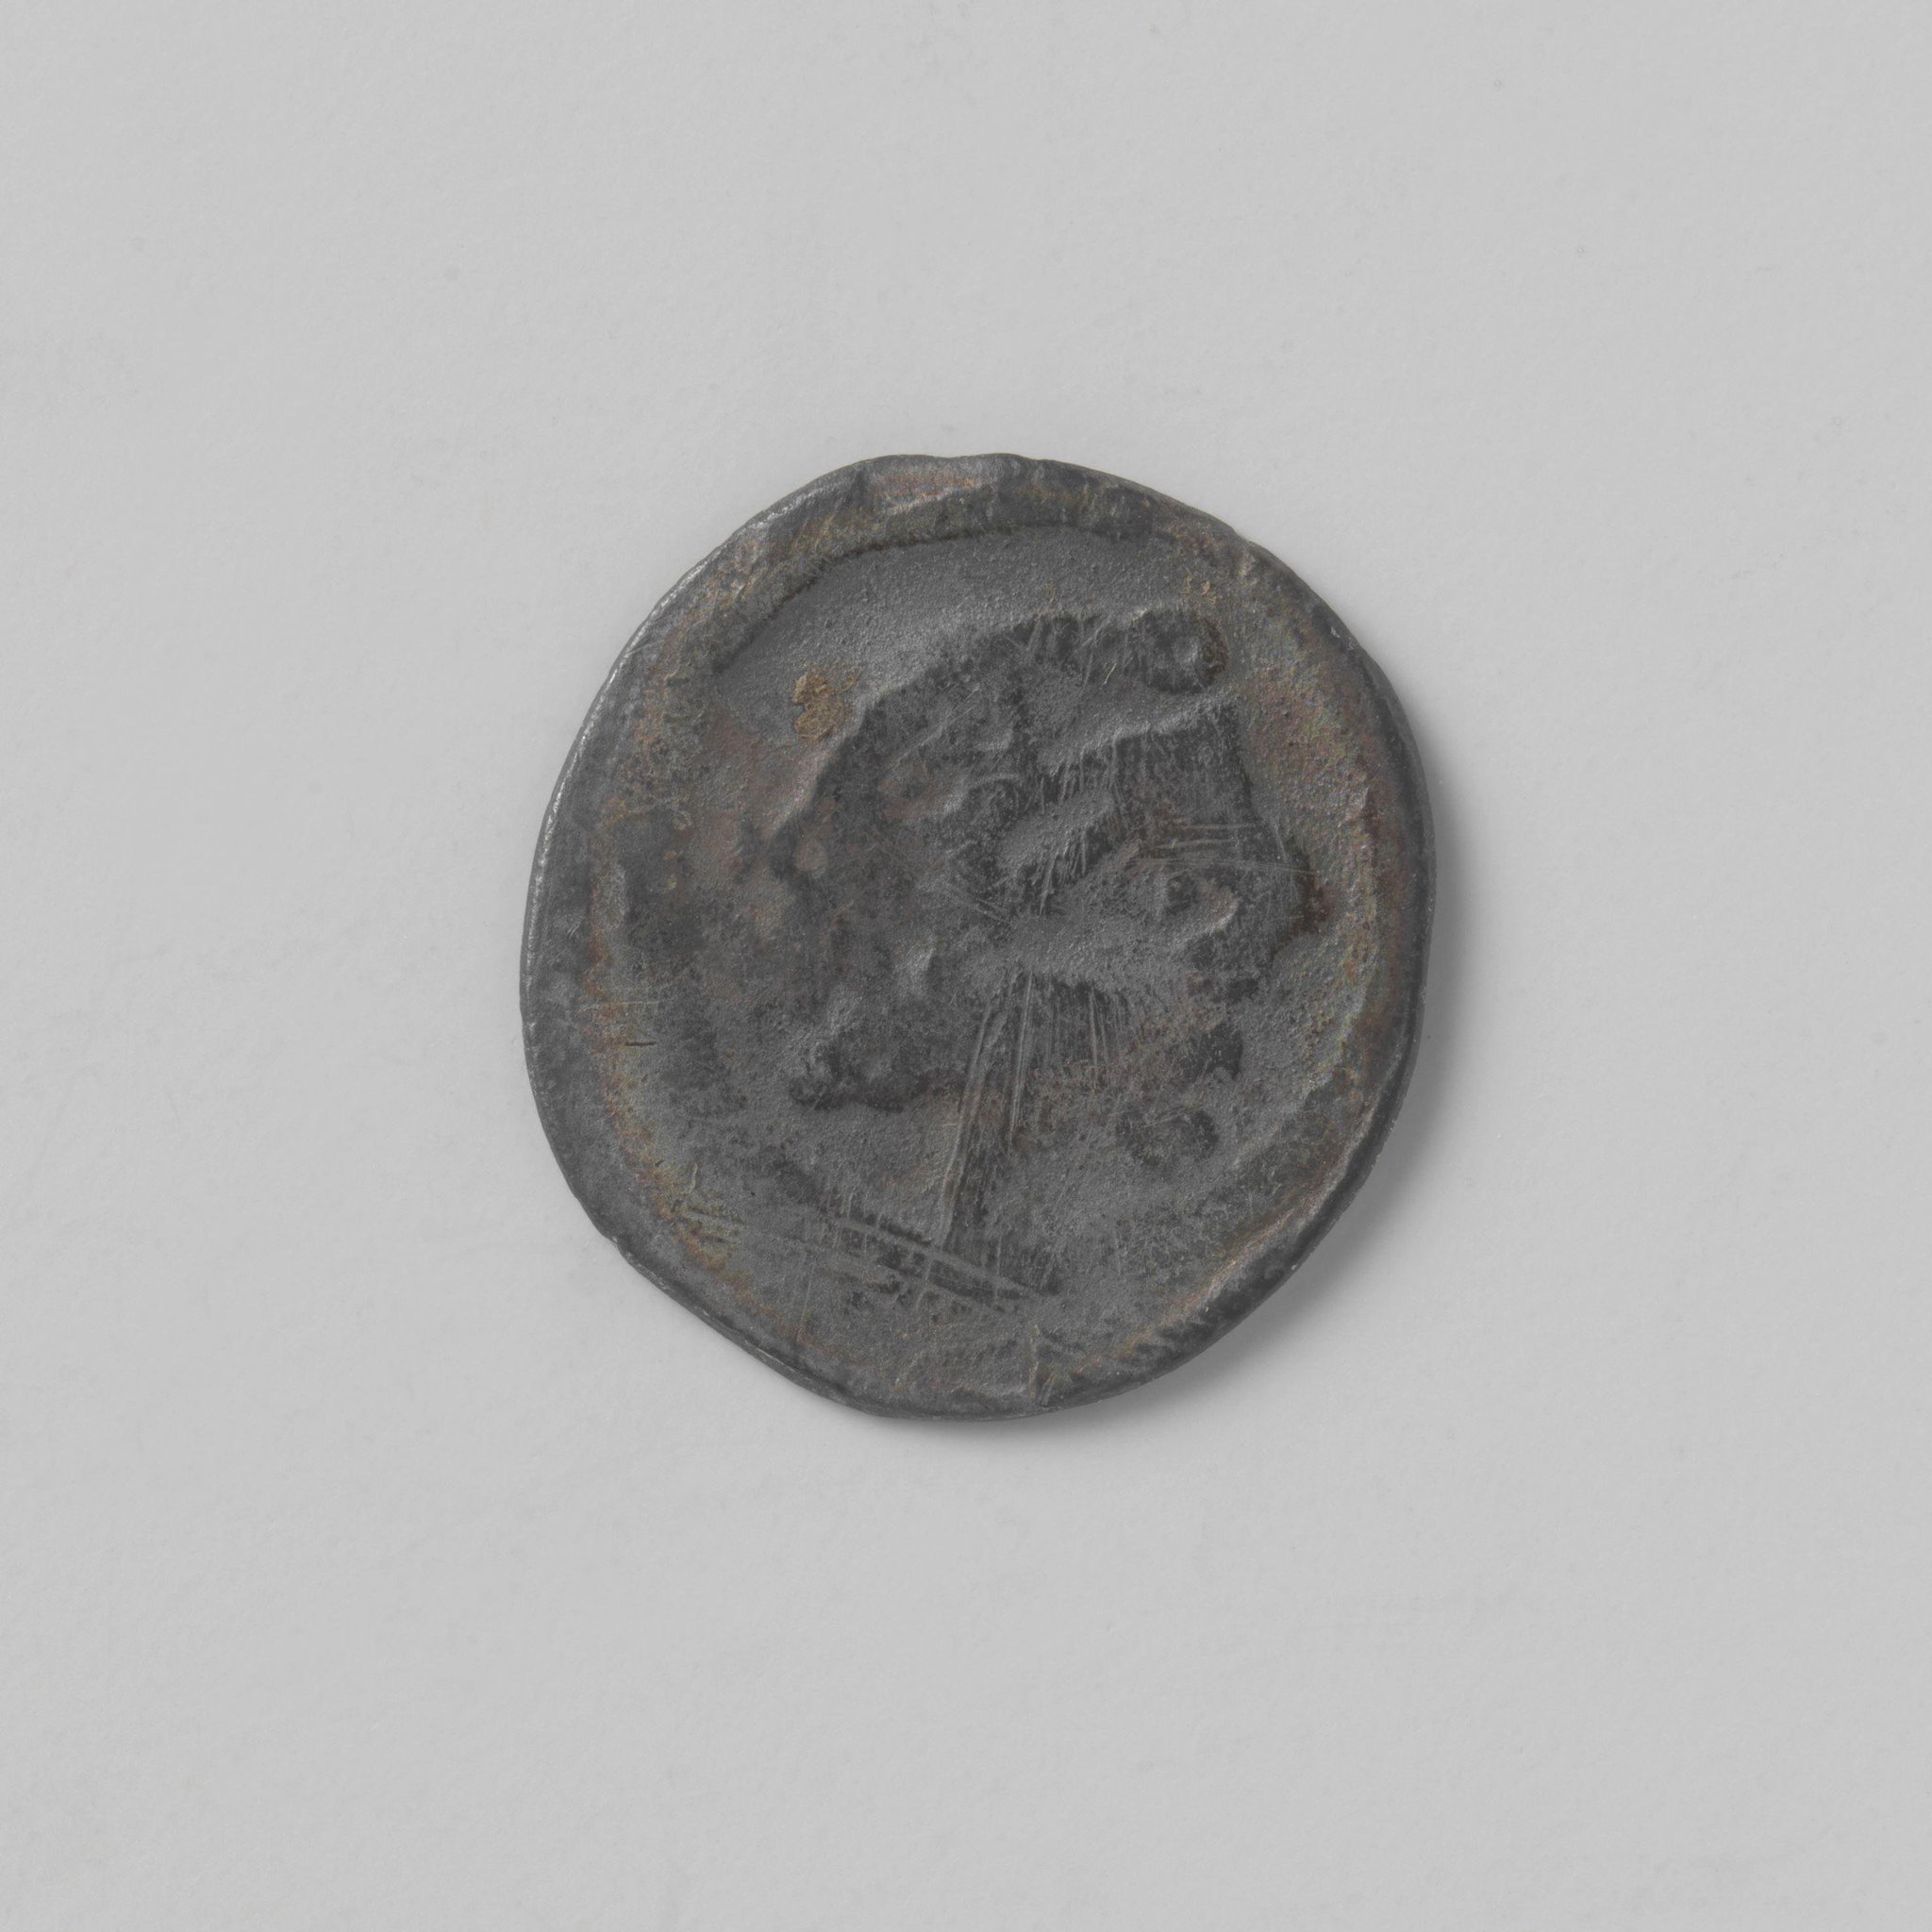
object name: penny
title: Holland, Floris IV, penning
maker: floris iv (graaf van holland)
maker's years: 1210-1234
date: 1222-1234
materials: silver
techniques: striking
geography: dordrecht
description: Zilveren munt. Voorzijde: hoofd met gravenmuts naar rechts. Keerzijde: kort dubbellijnig kruis.